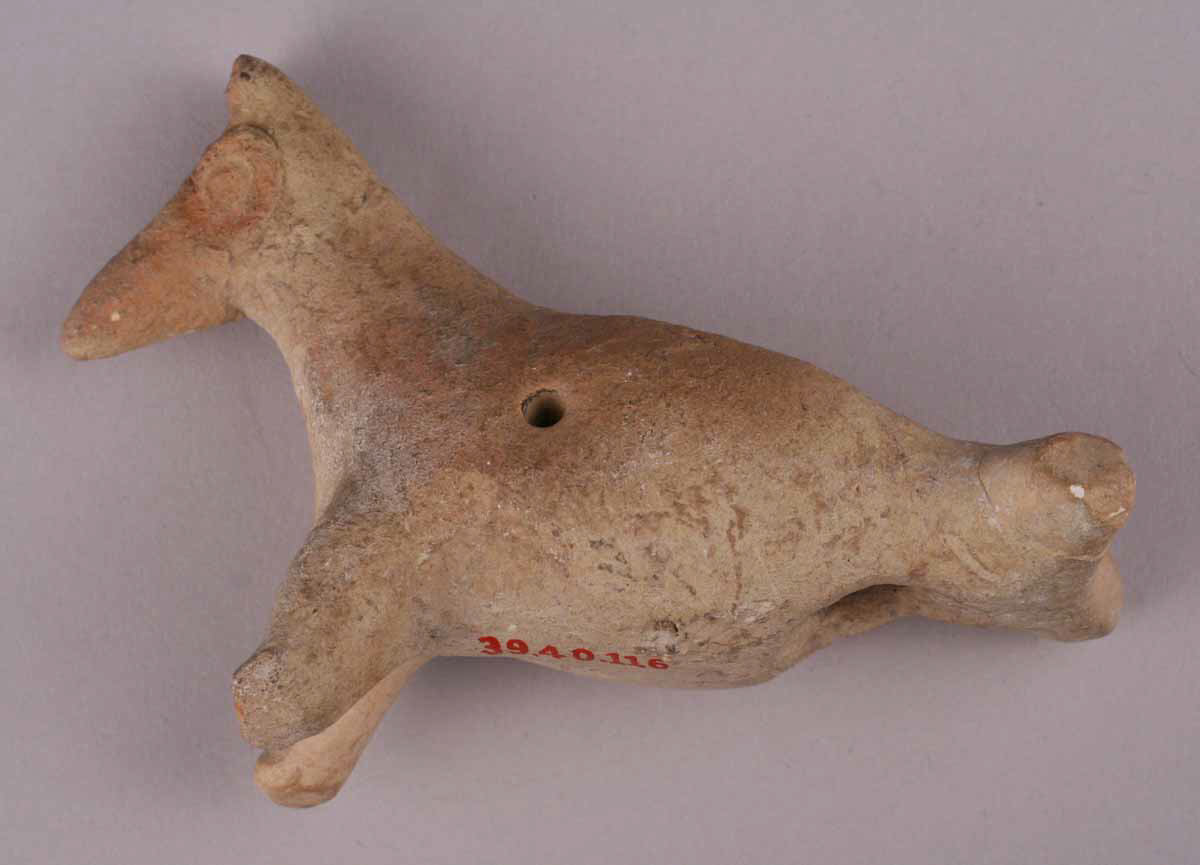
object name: whistle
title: Animal-Shaped Whistle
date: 801-1000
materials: earthenware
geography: iran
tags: musical instruments,horses